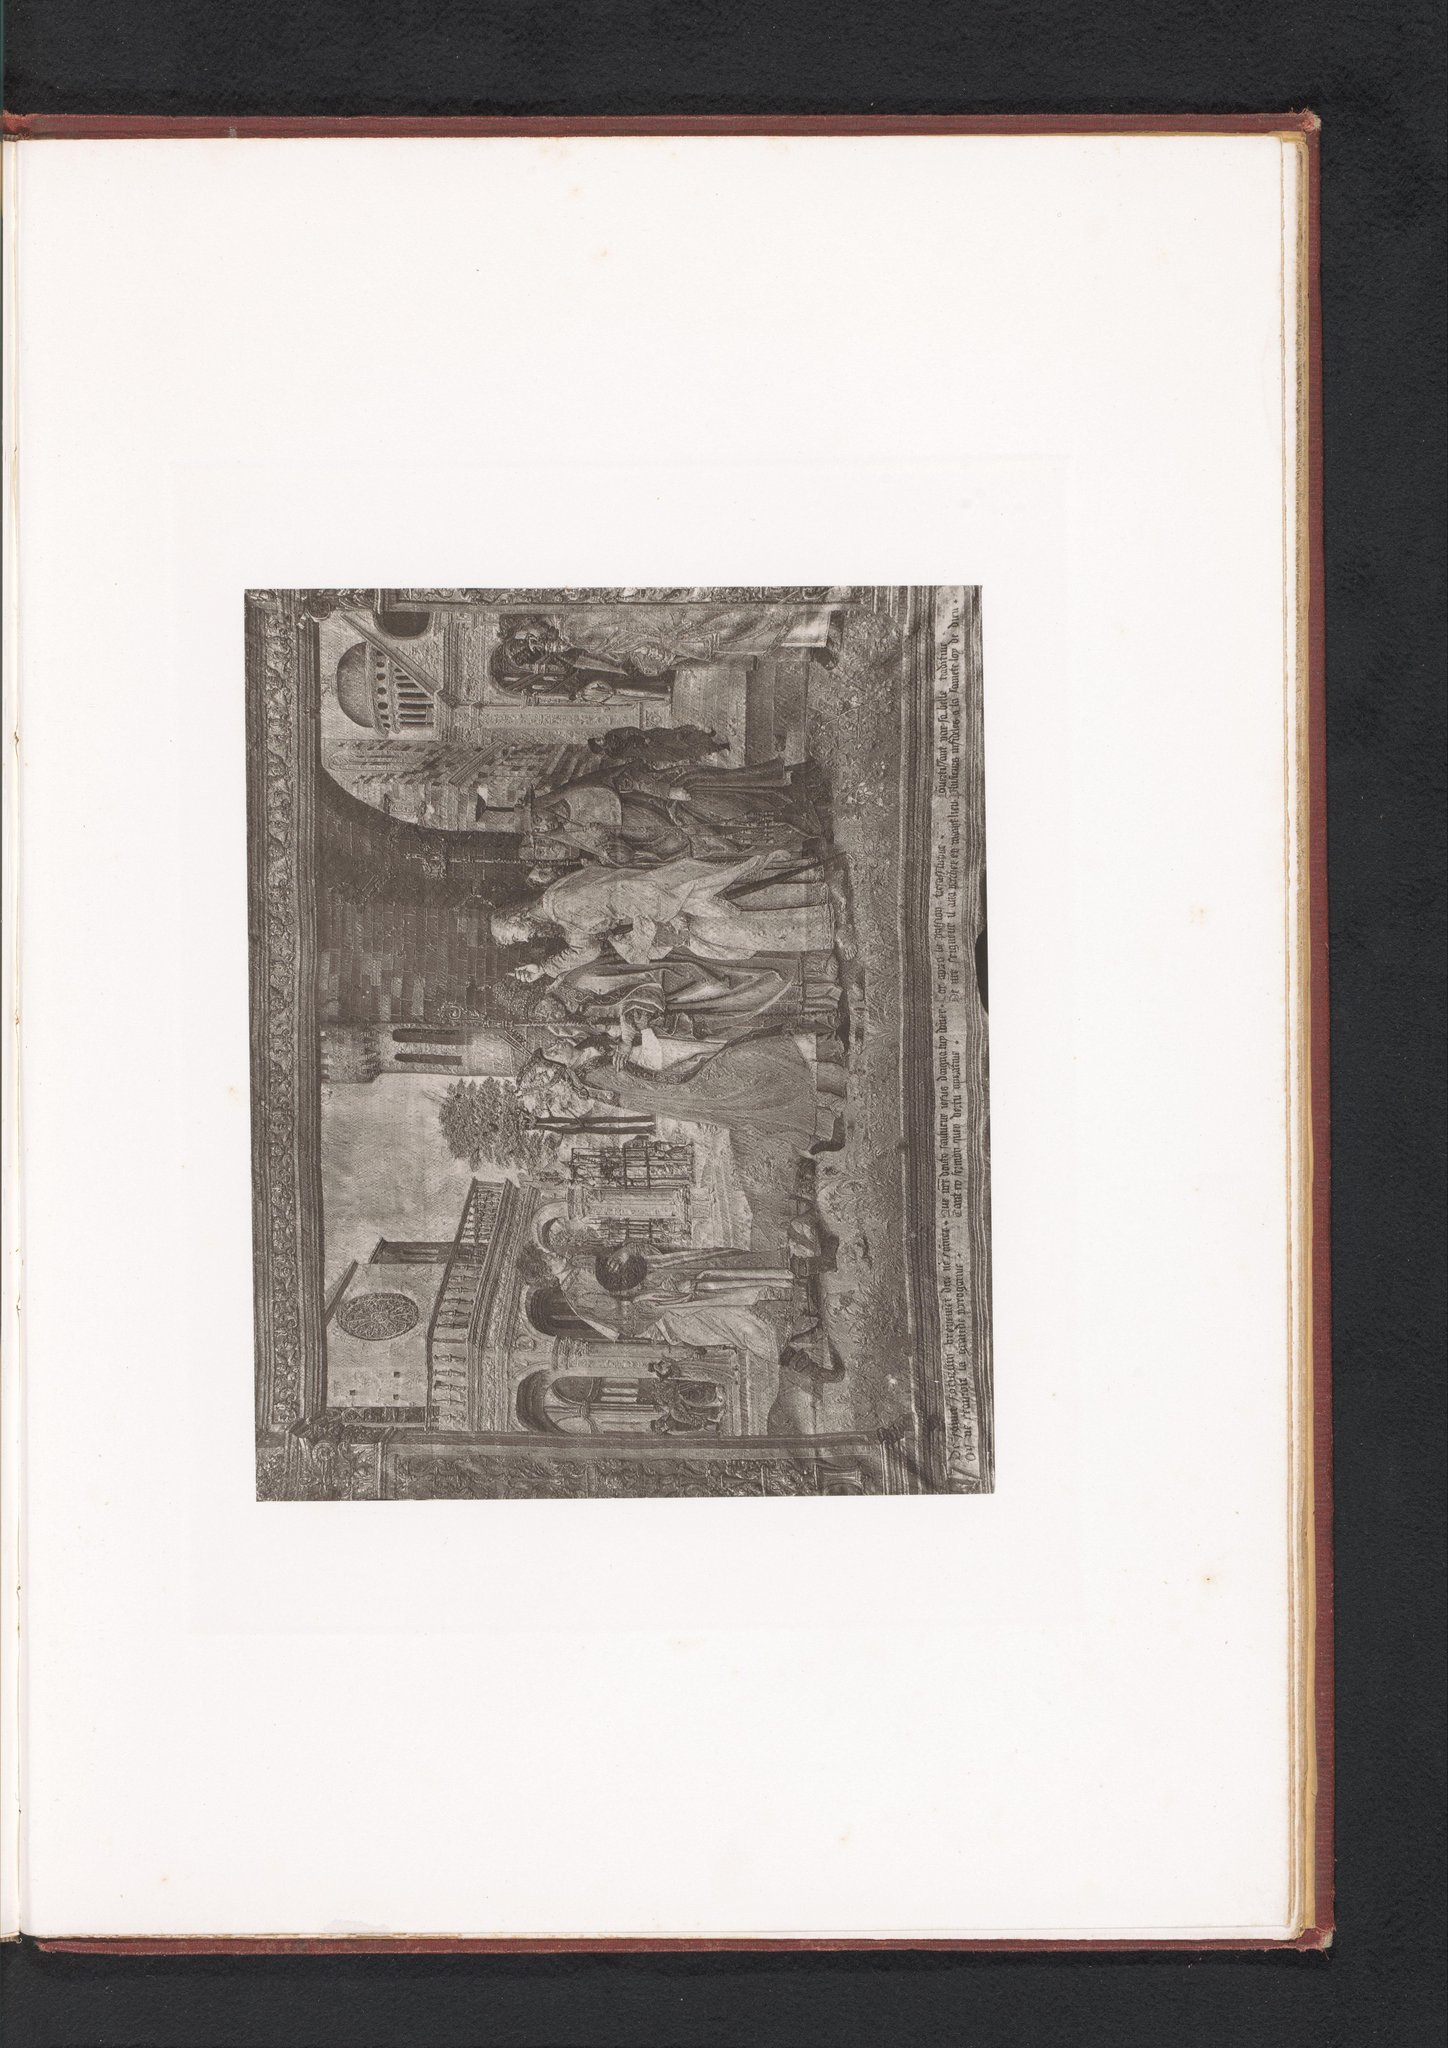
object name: photomechanical print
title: Wandtapijt met een voorstelling uit het leven van de heilige Saturninus van Toulouse, opgesteld tijdens de Exposition Rétrospective van 1873 in Tours, Frankrijk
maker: gabriel blaise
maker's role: printer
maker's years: 1827-1897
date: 1873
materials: paper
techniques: woodburytype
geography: tours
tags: saturninus (sernin), martyr and bishop of toulouse; possible attributes: bull, tapestry, temporary exhibition, 'salon'